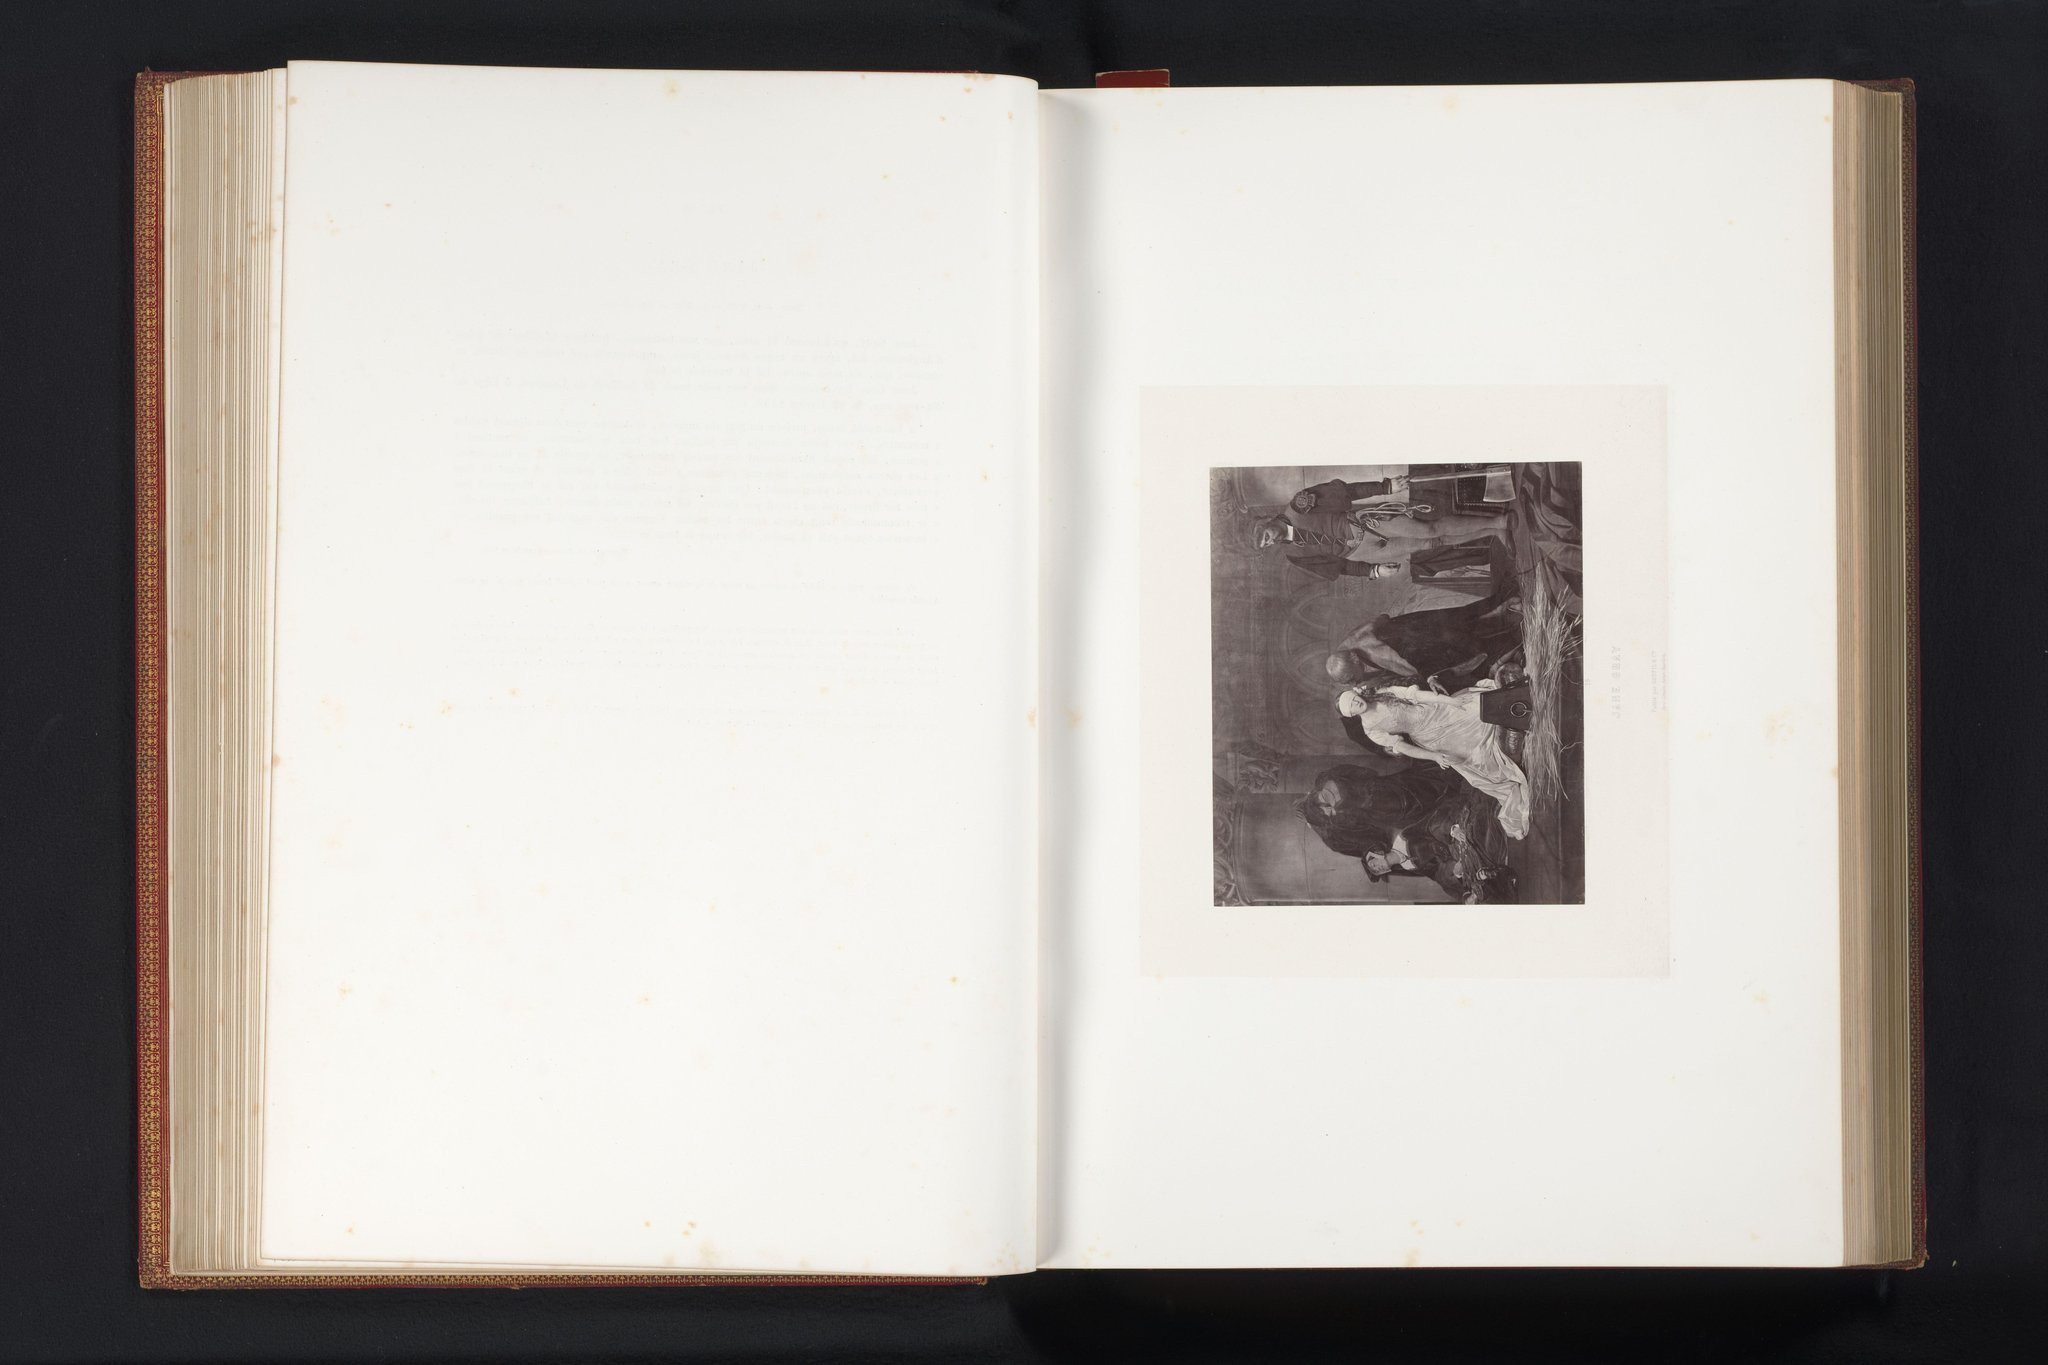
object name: page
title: Fotoreproductie van een schilderij van de terechtstelling van Jane Grey door Paul Delaroche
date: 1853-1858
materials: paper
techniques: albumen print, engraving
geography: paris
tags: london, death penalty, execution, executioner, hangman, blindfold - aa - female human figure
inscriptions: check stamp: ‘Goupil & Cie’